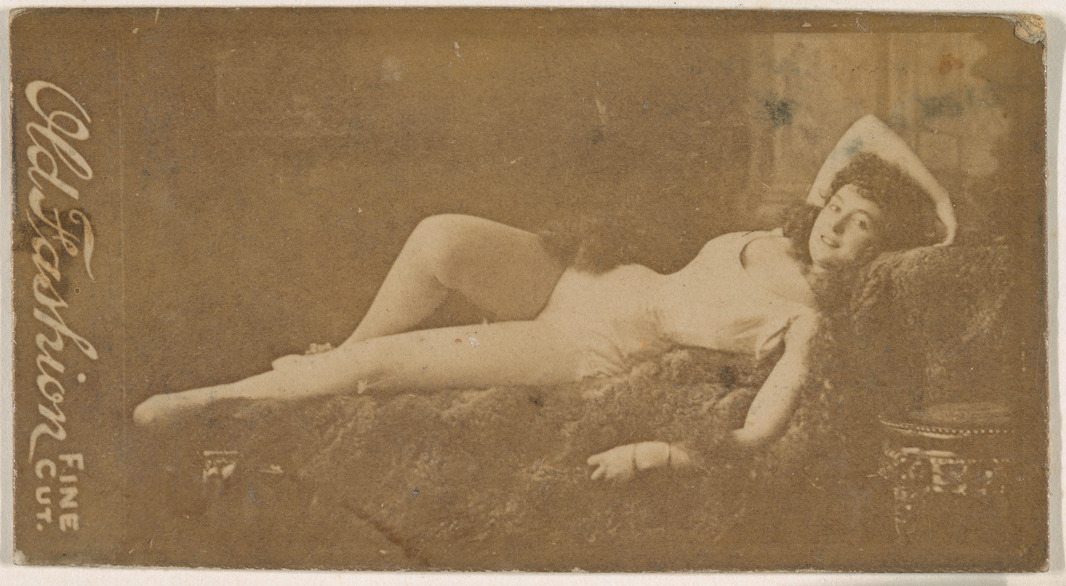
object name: photograph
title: Actress reclining on sofa, from the Actresses series (N664) promoting Old Fashion Fine Cut Tobacco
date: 1888-1890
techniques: albumen silver print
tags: portraits,women,actresses